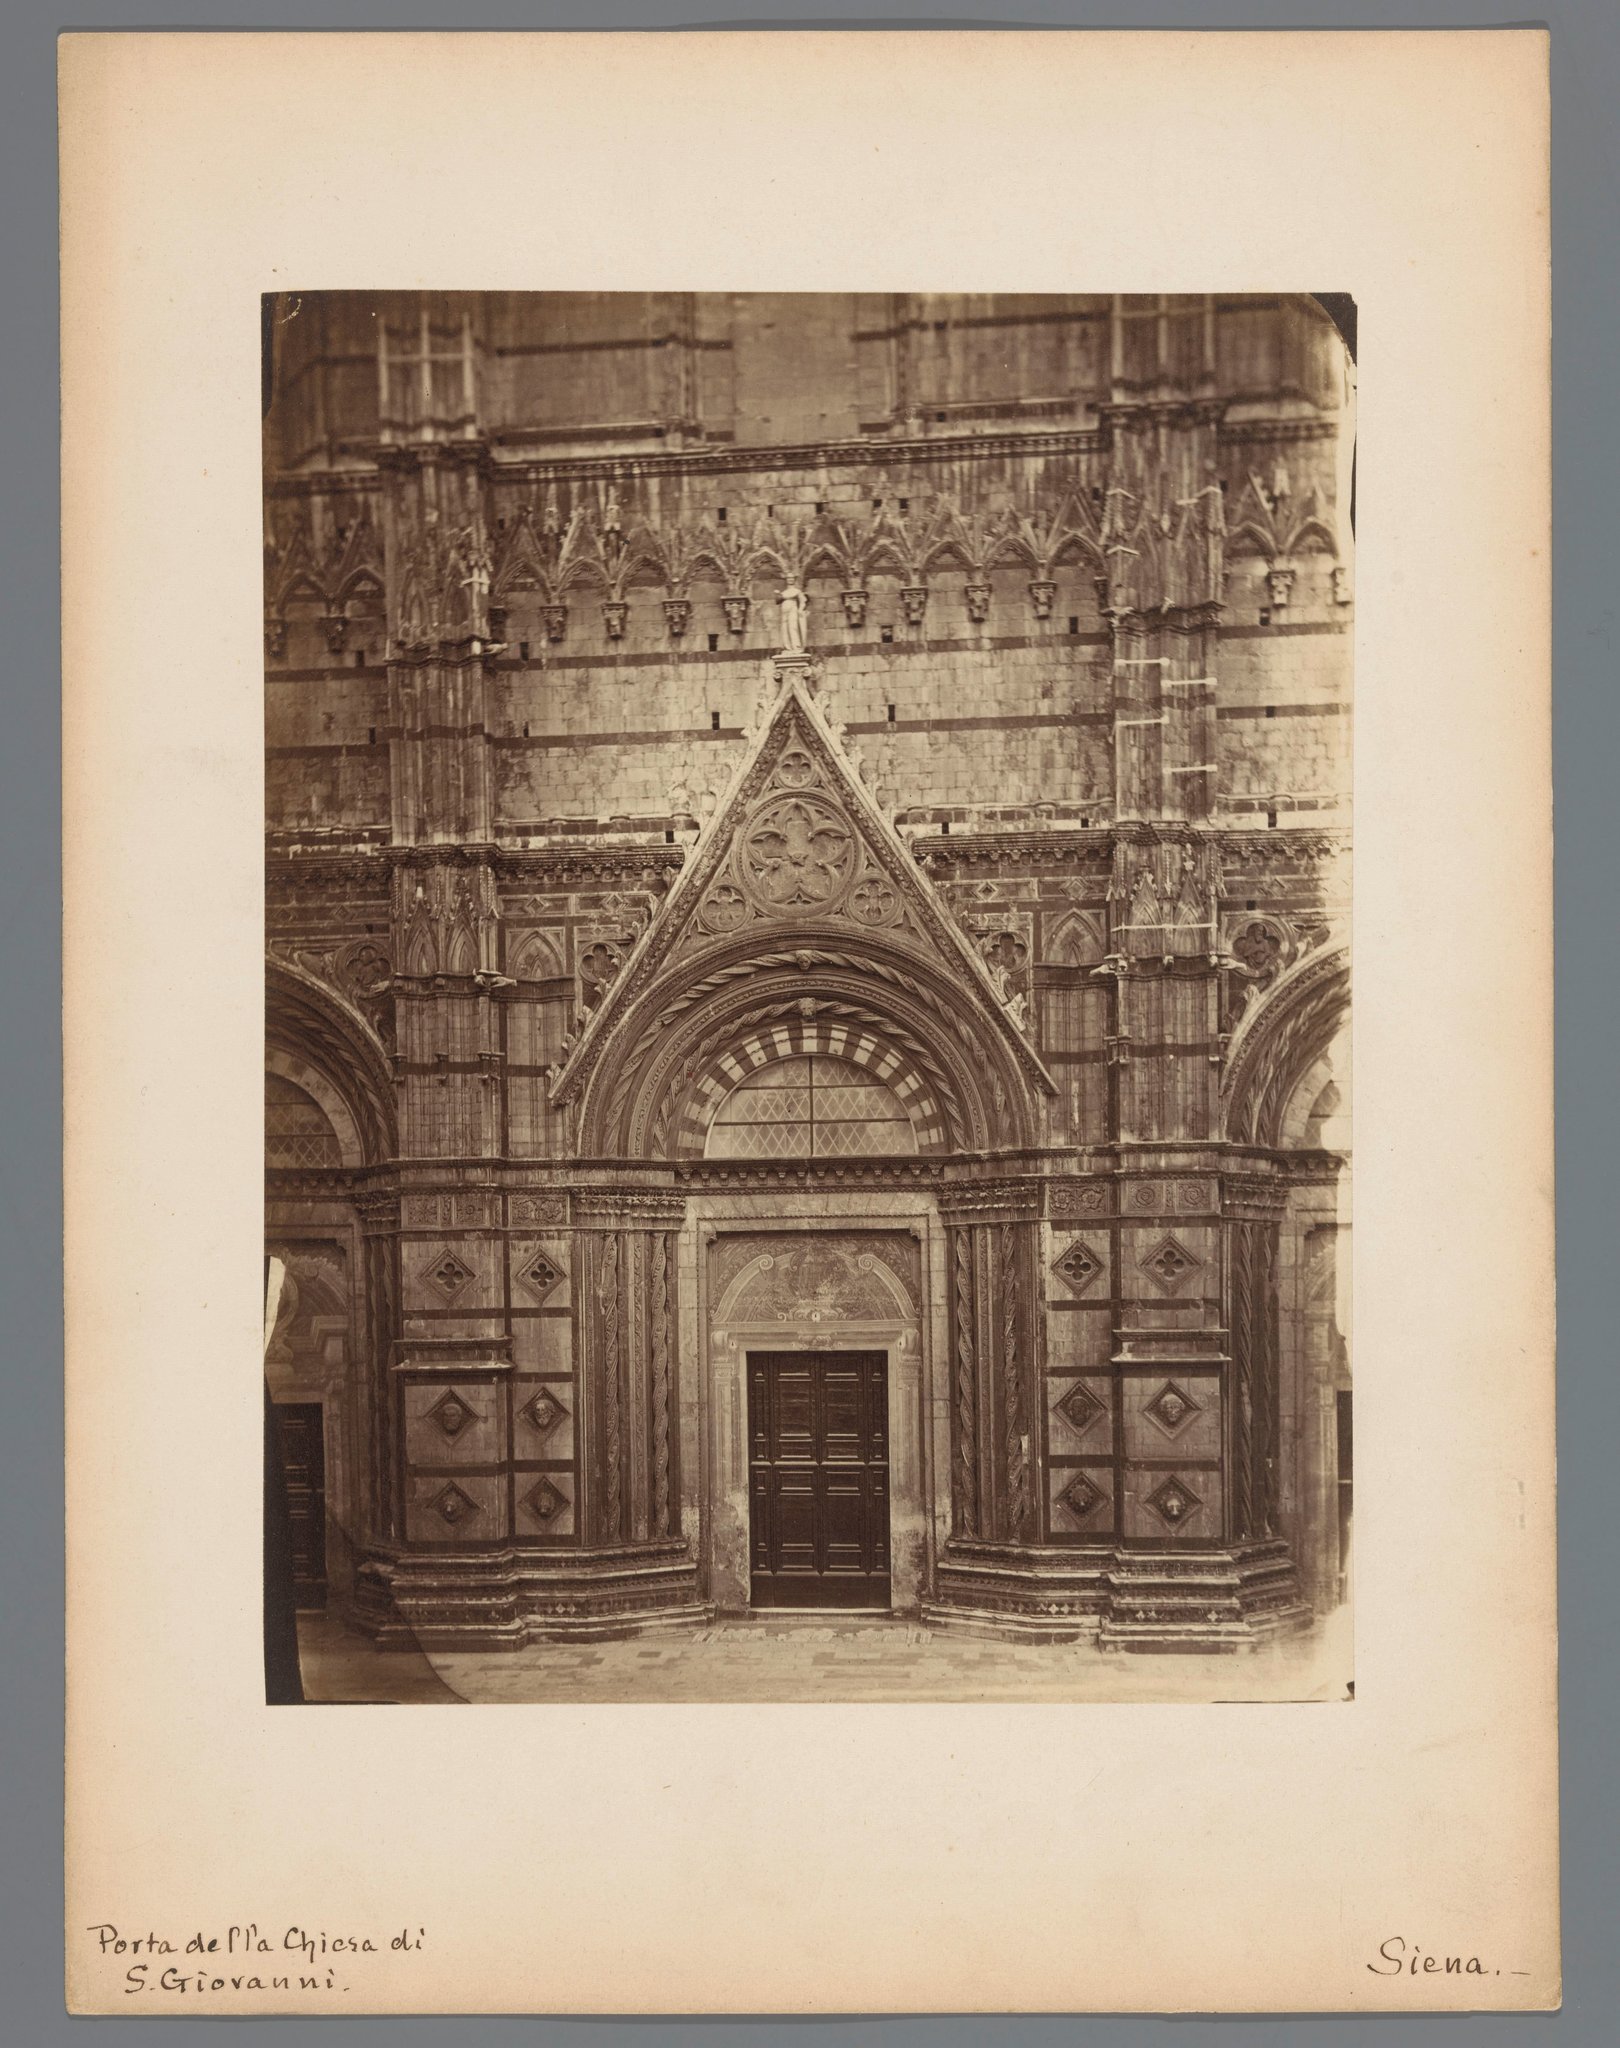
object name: photograph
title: Porta della chiesa di S.Giovanni Siena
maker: Anonymous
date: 1875-1900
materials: cardboard, photographic support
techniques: albumen print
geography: siena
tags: parts of church exterior and annexes: porch - qq - small church, chapel, church (exterior)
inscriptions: collector's mark: Lugt 3937